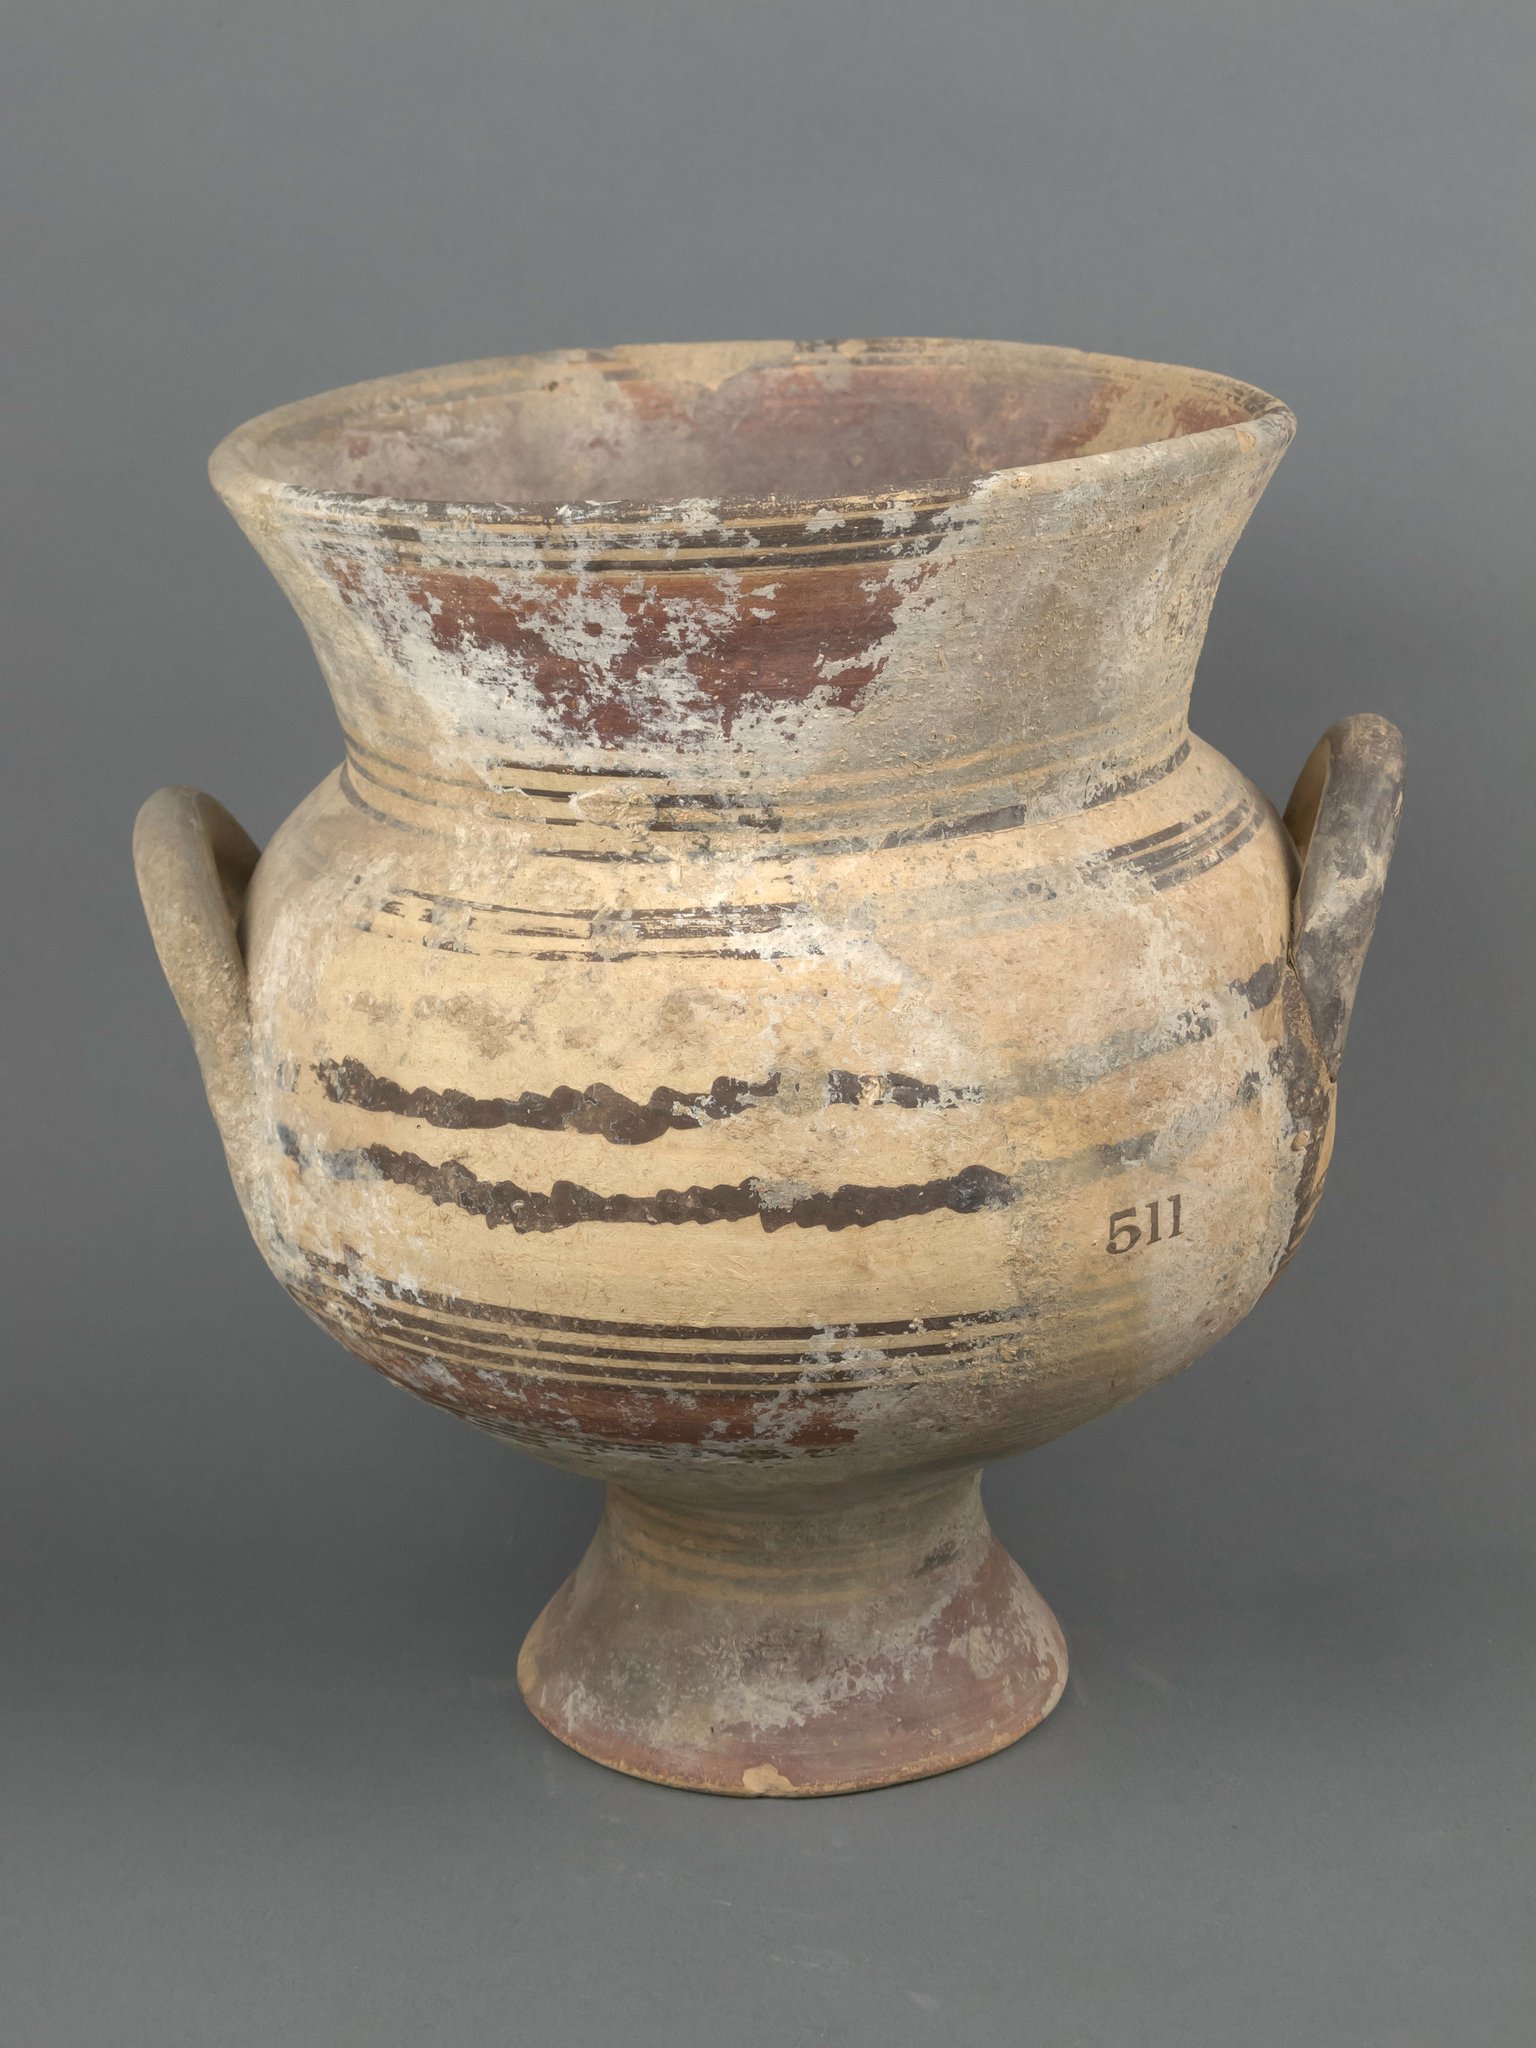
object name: amphora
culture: cypriot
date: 850-600 BCE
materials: terracotta